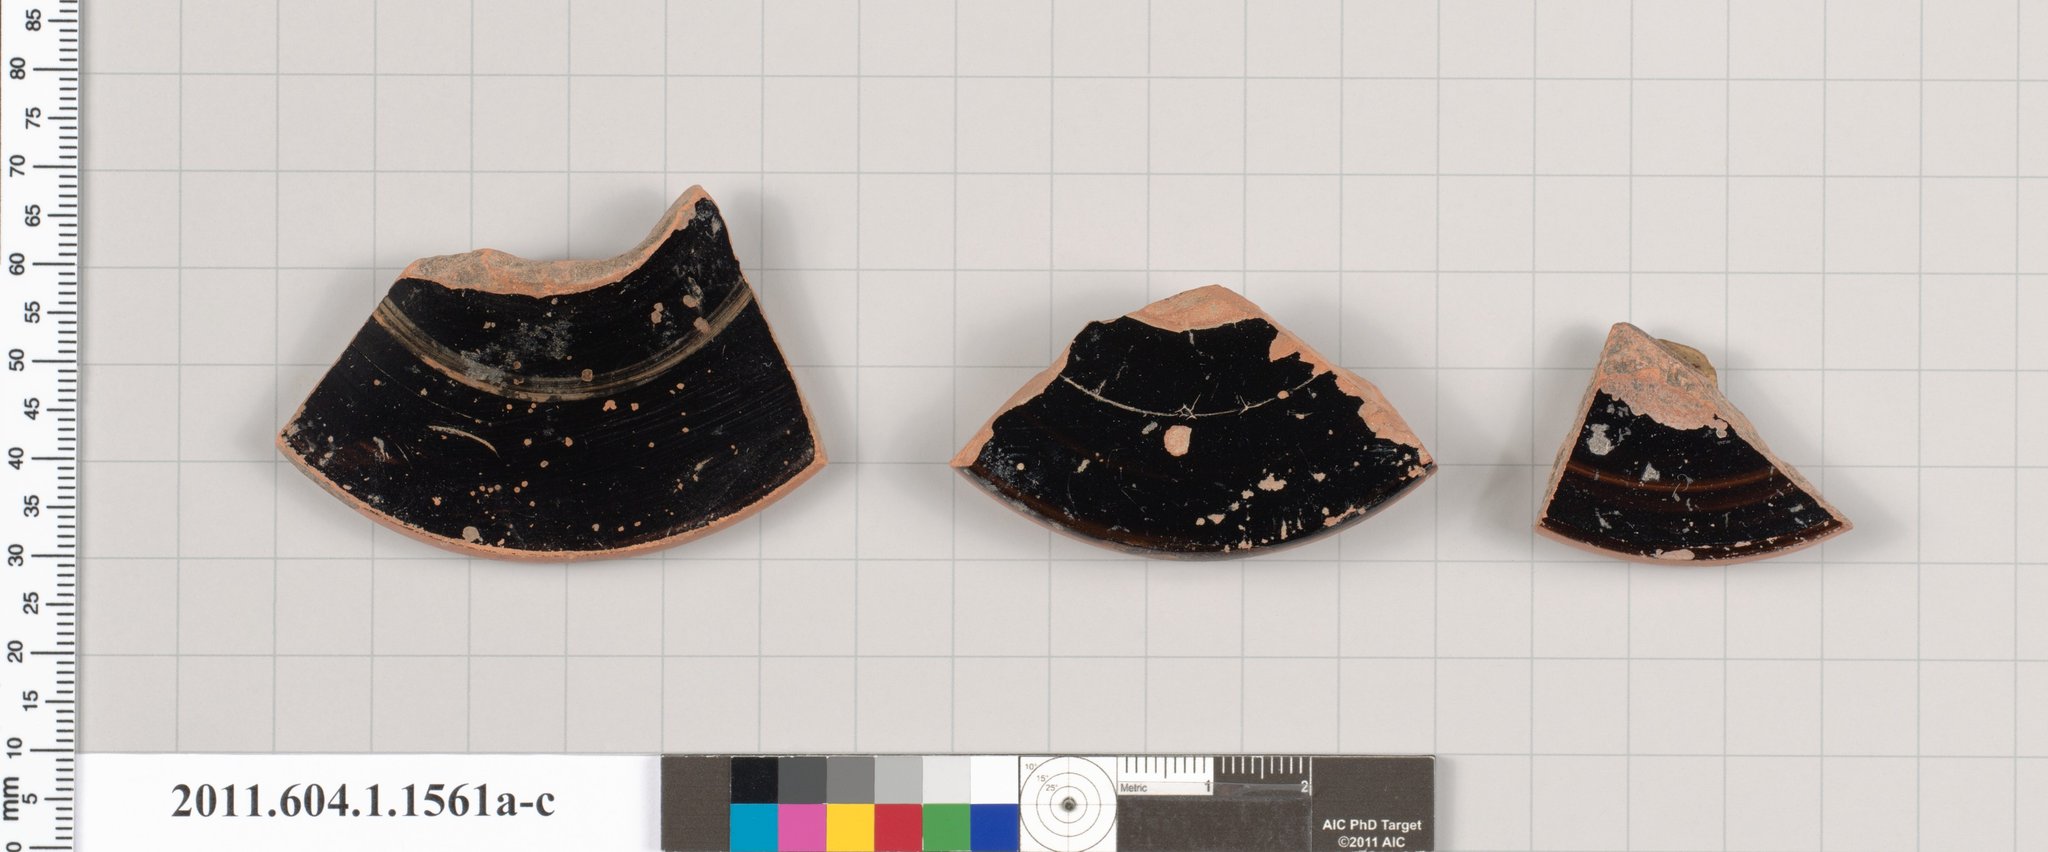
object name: kylix fragment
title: Terracotta fragments of kylikes (drinking cups)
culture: greek, attic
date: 500-401 BCE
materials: terracotta